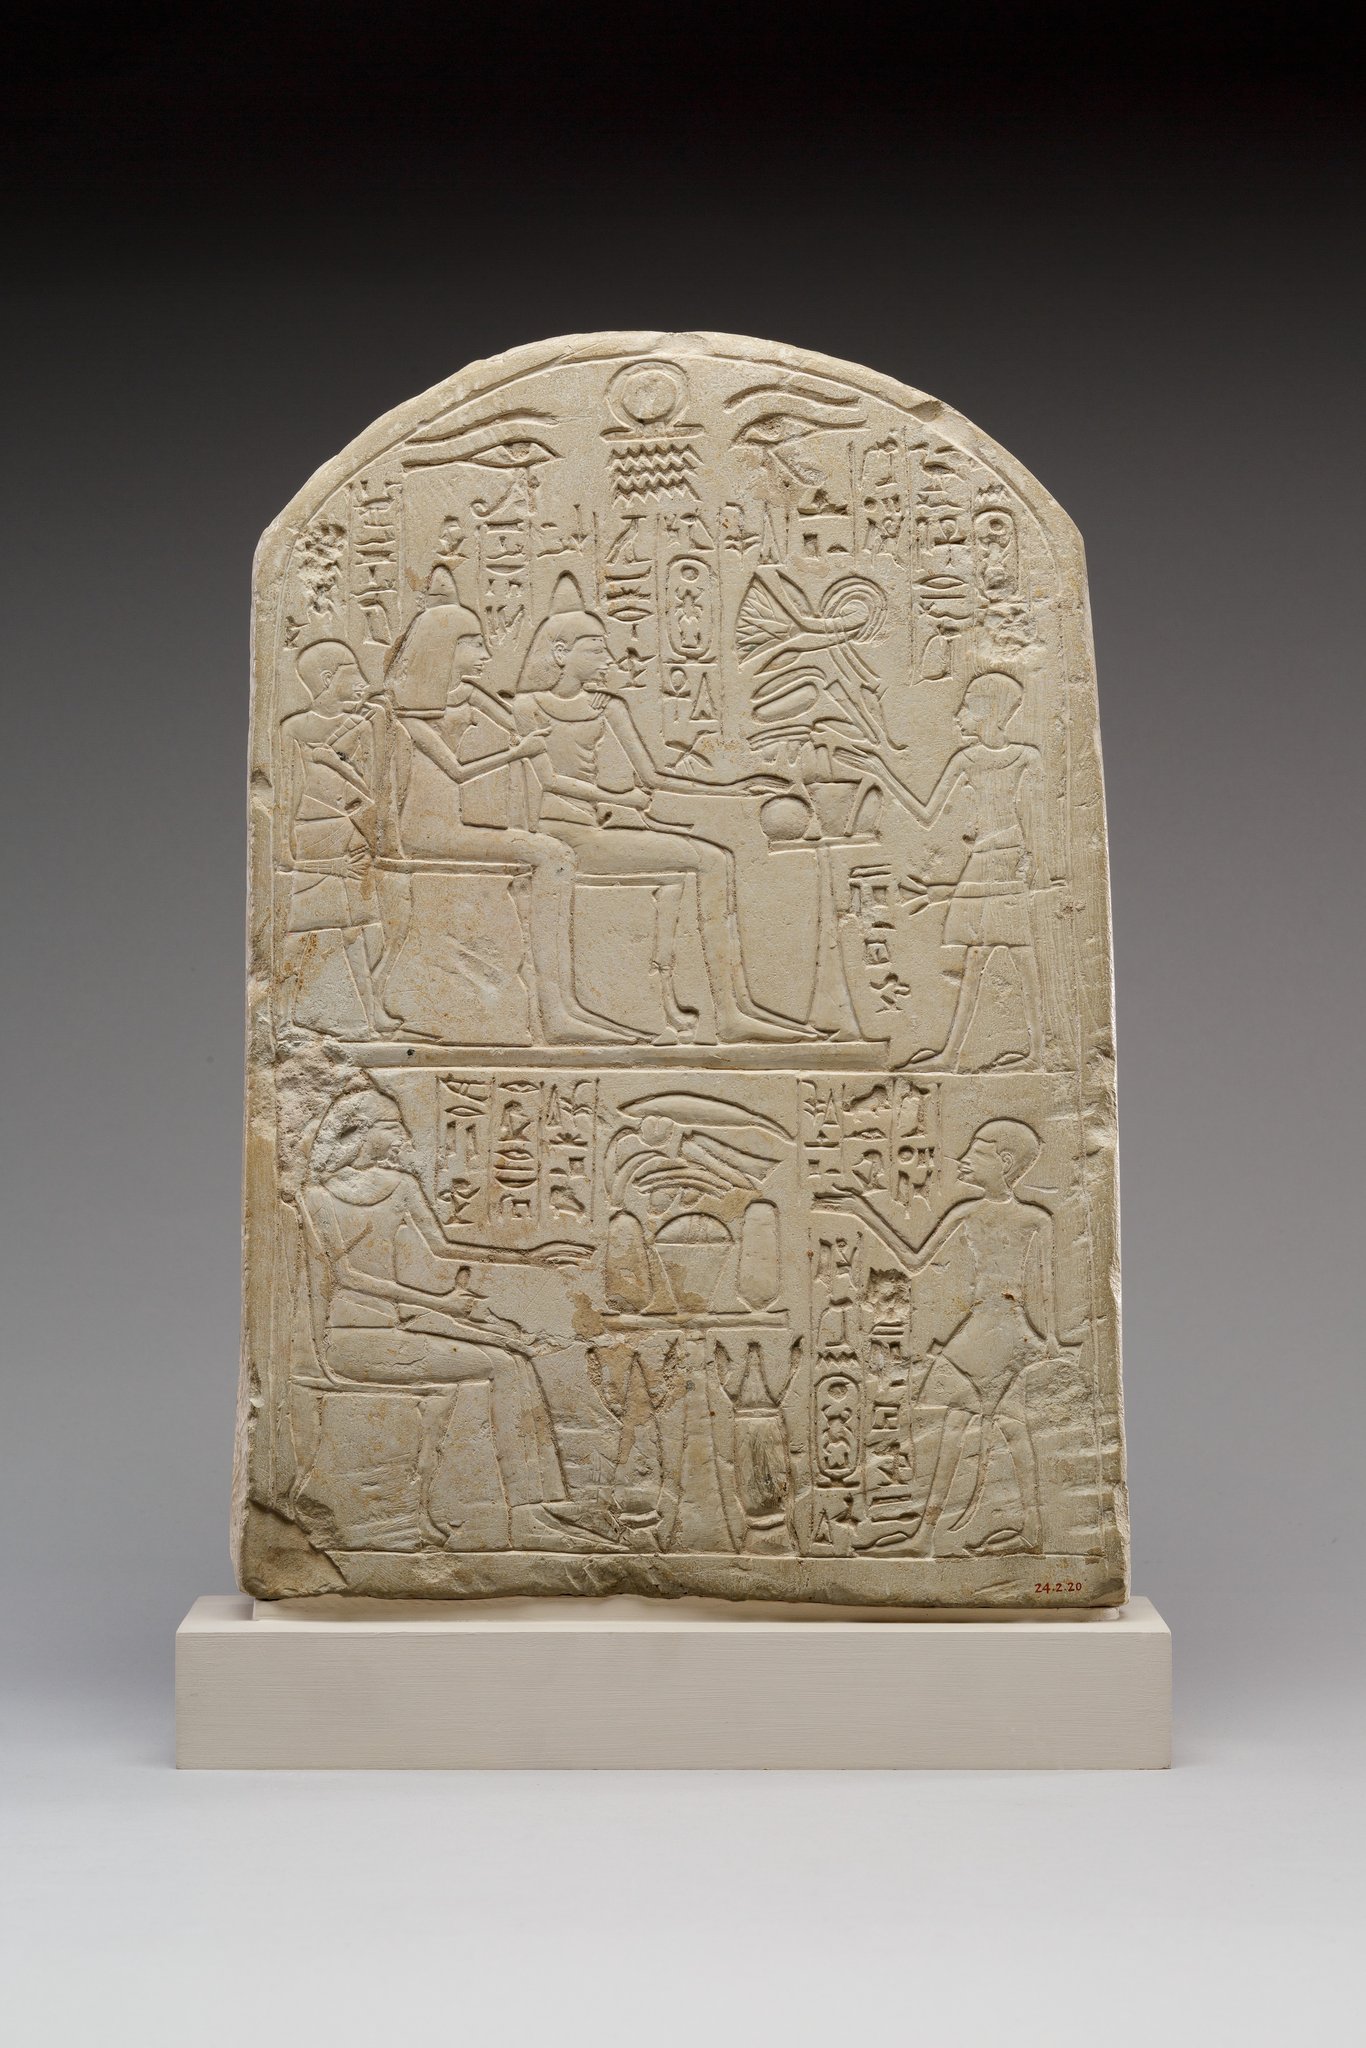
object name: stela, amenemopet, priest, senwosret i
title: Stela of Amenemopet, a Priest of Senwosret I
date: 1479-1391 BCE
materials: limestone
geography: egypt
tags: men,hieroglyphs